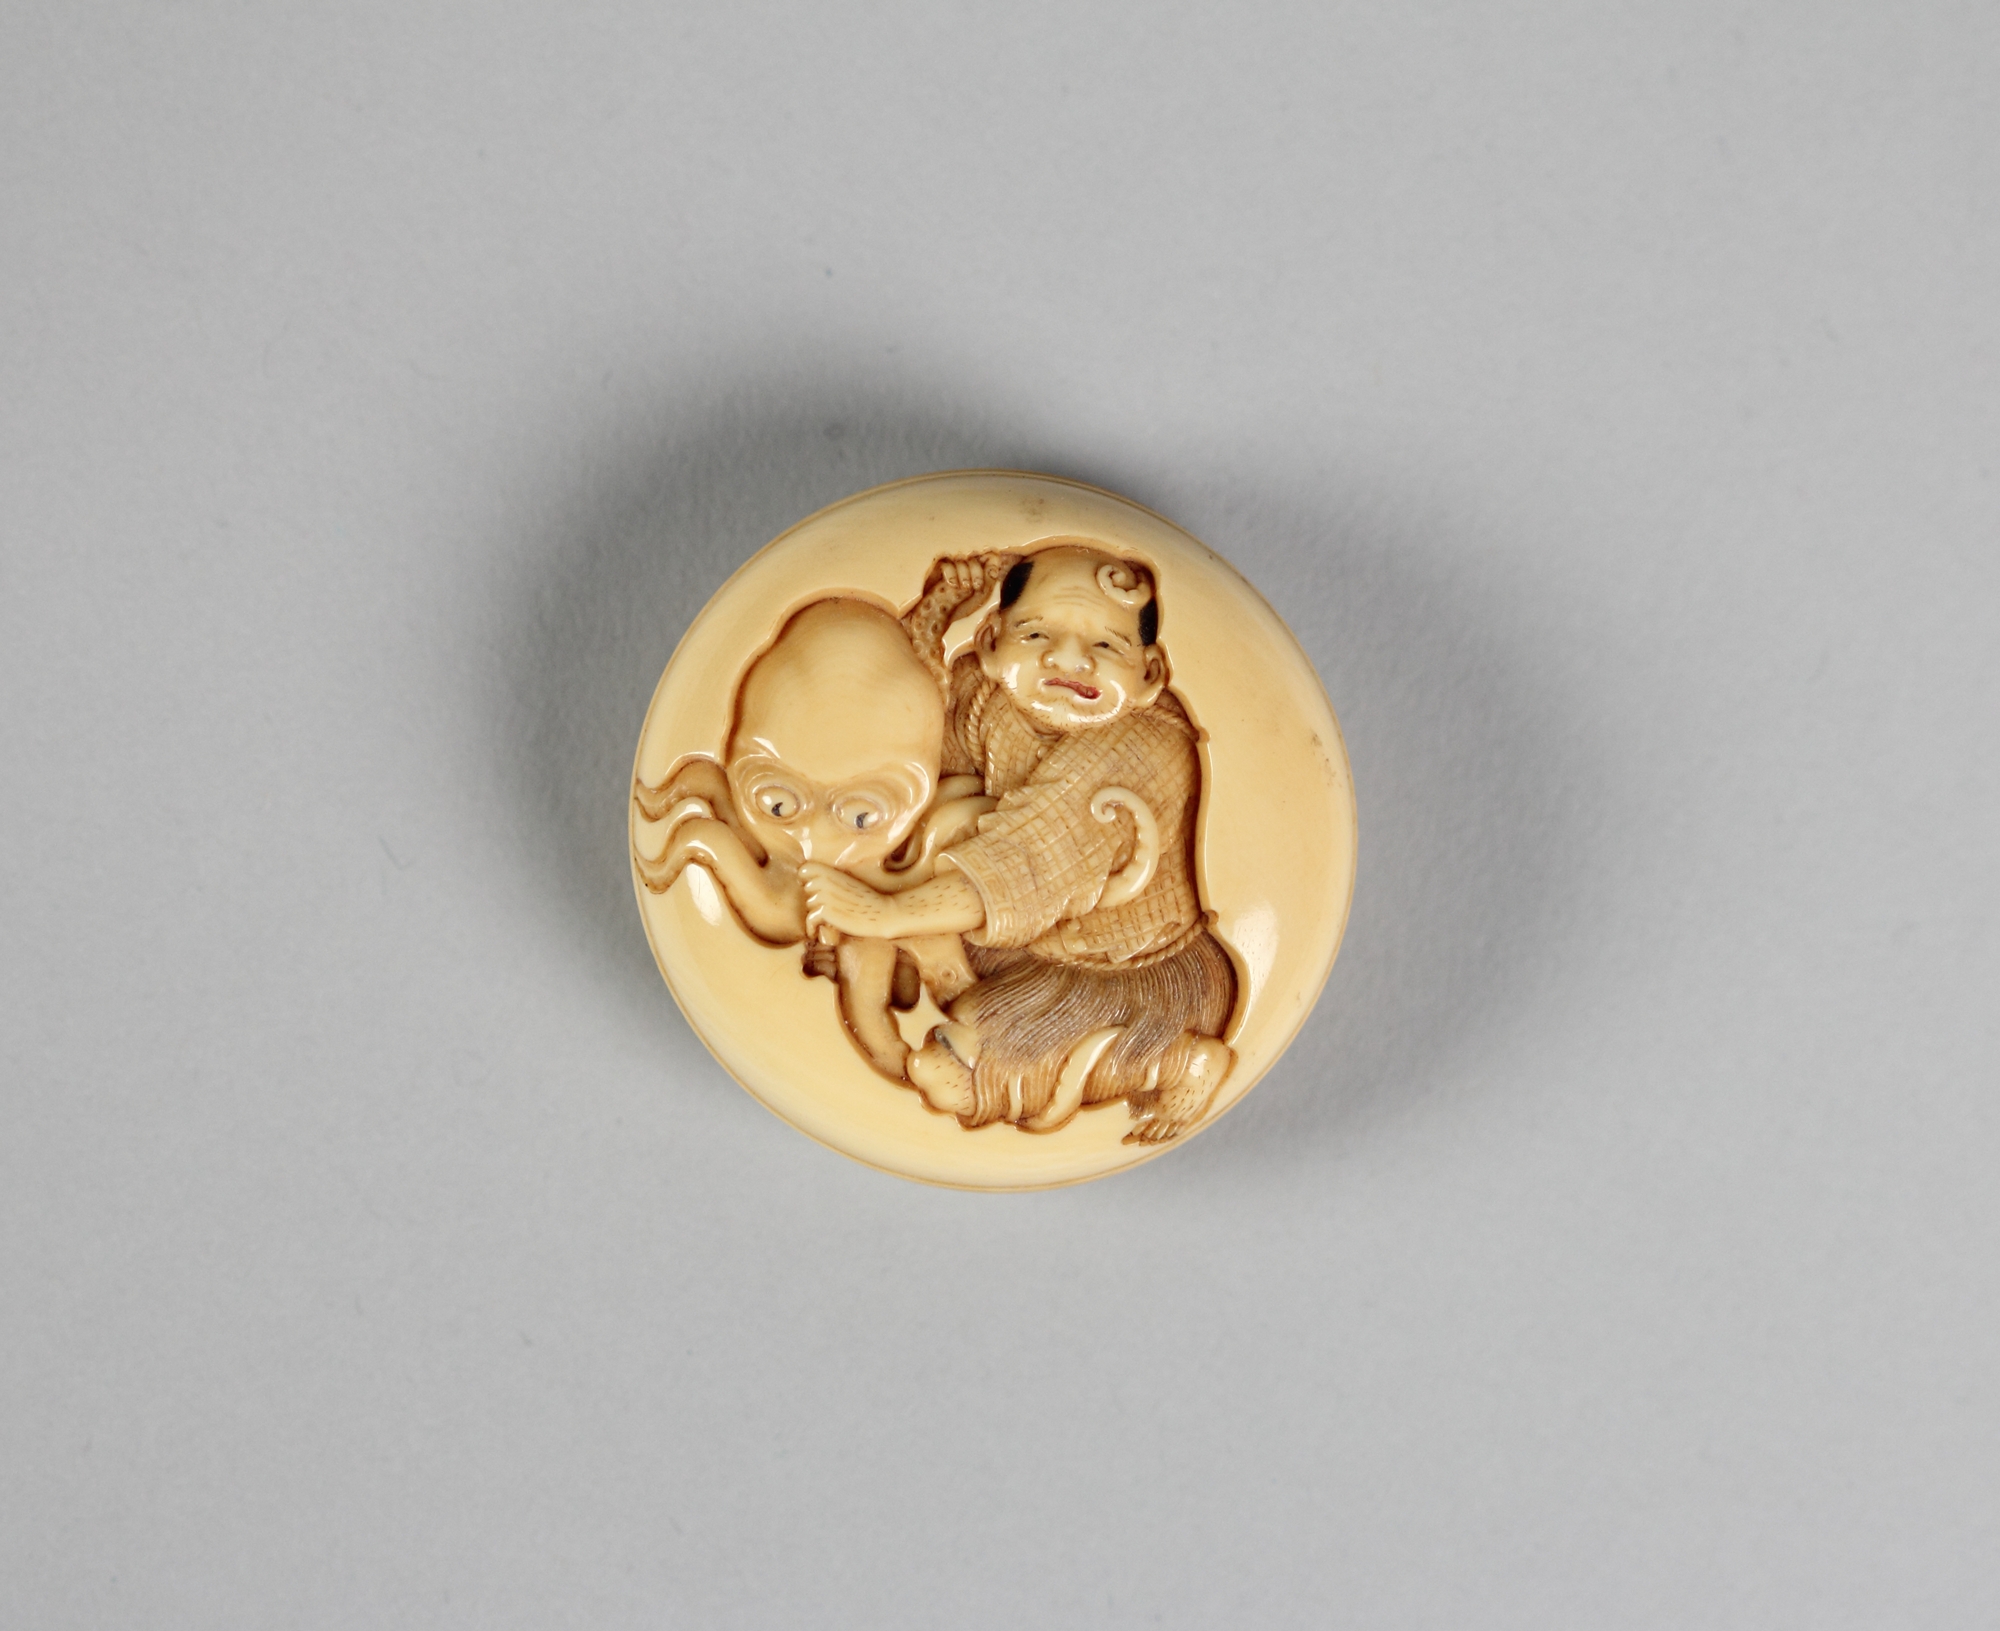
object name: netsuke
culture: japanese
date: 1801-1900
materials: ivory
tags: men